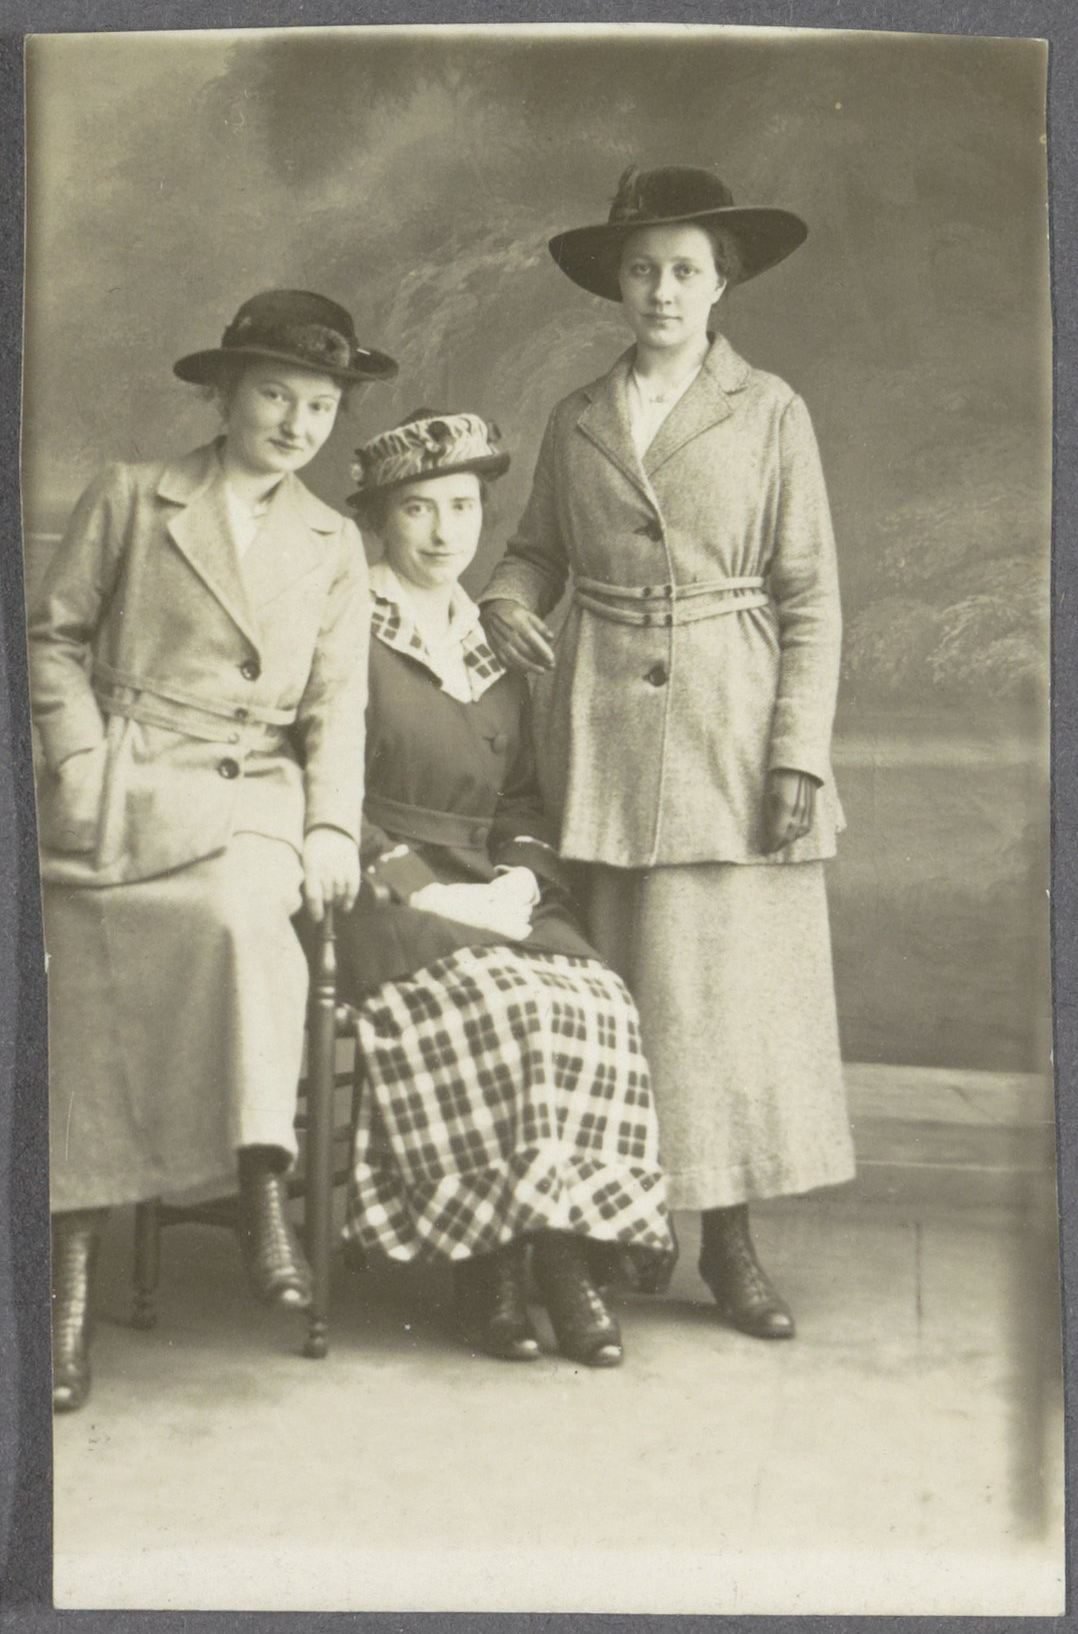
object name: album leaf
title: Groepsportret van drie vrouwen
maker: Anonymous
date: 1920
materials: cardboard, paper, photographic support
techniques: gelatin silver print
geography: netherlands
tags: adult woman, studio requisites ~ photographer, historical persons, netherlands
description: Onderdeel van Fotoalbum met portretten vervaardigd door Nederlandse studio's waaronder automaatfoto's.